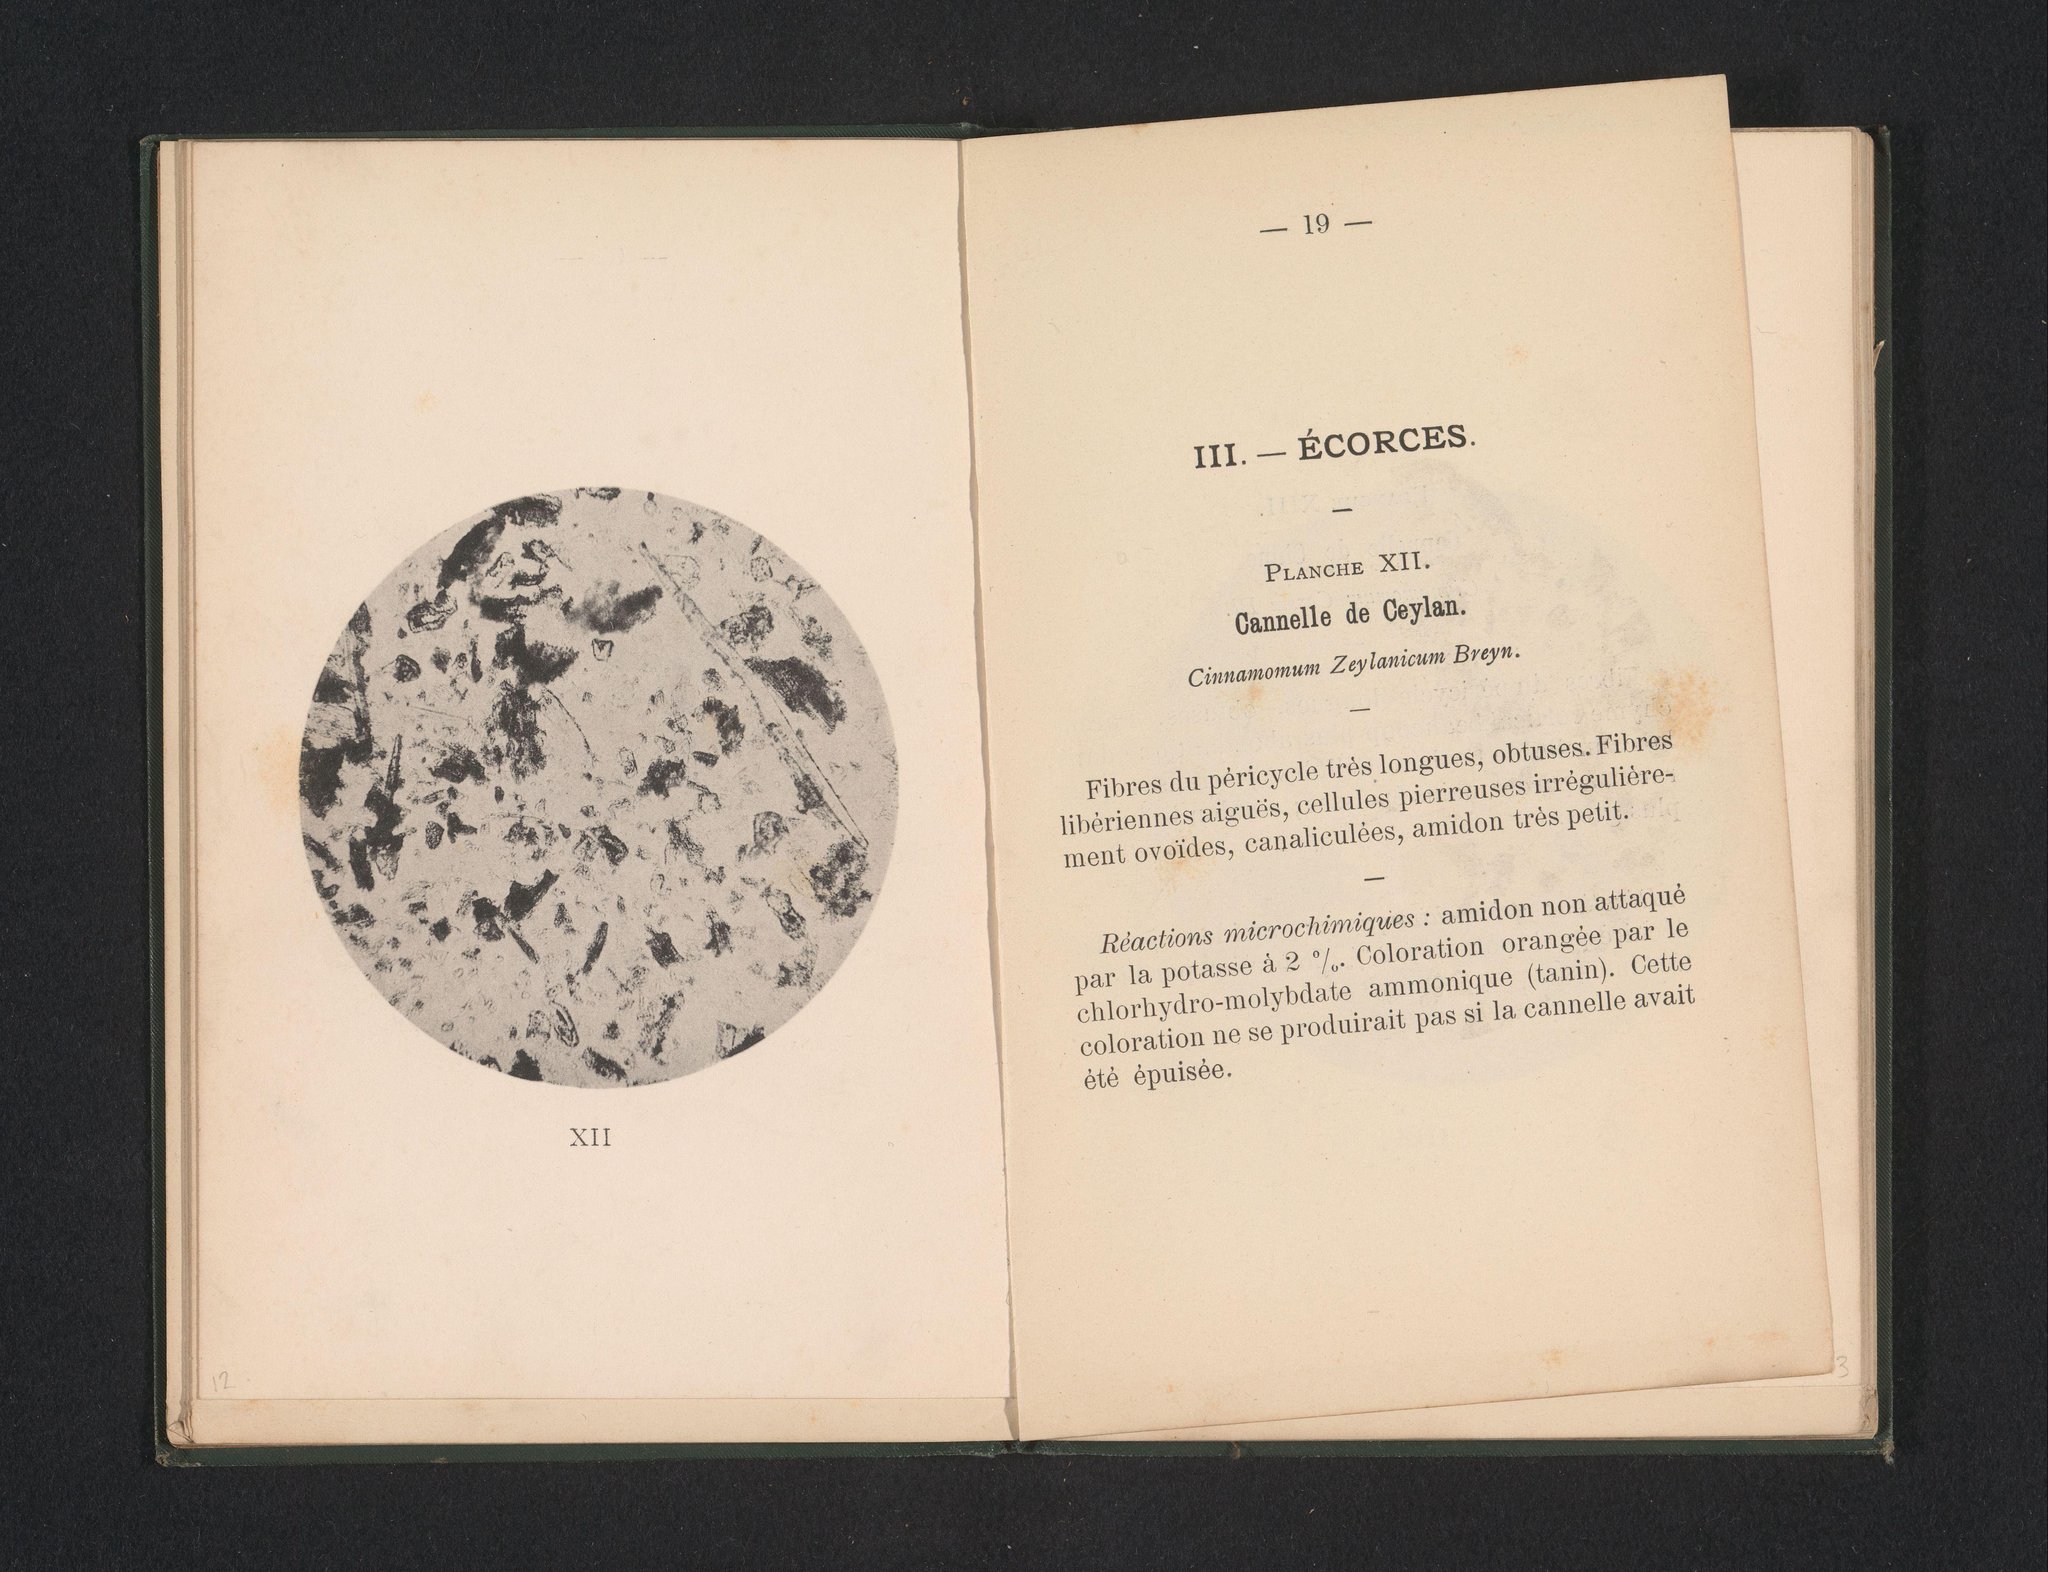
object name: page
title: Microscopische weergave van Ceylon kaneel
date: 1891-1896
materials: paper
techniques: photograph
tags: microscope (+ scientific research)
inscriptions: number: ‘XII’